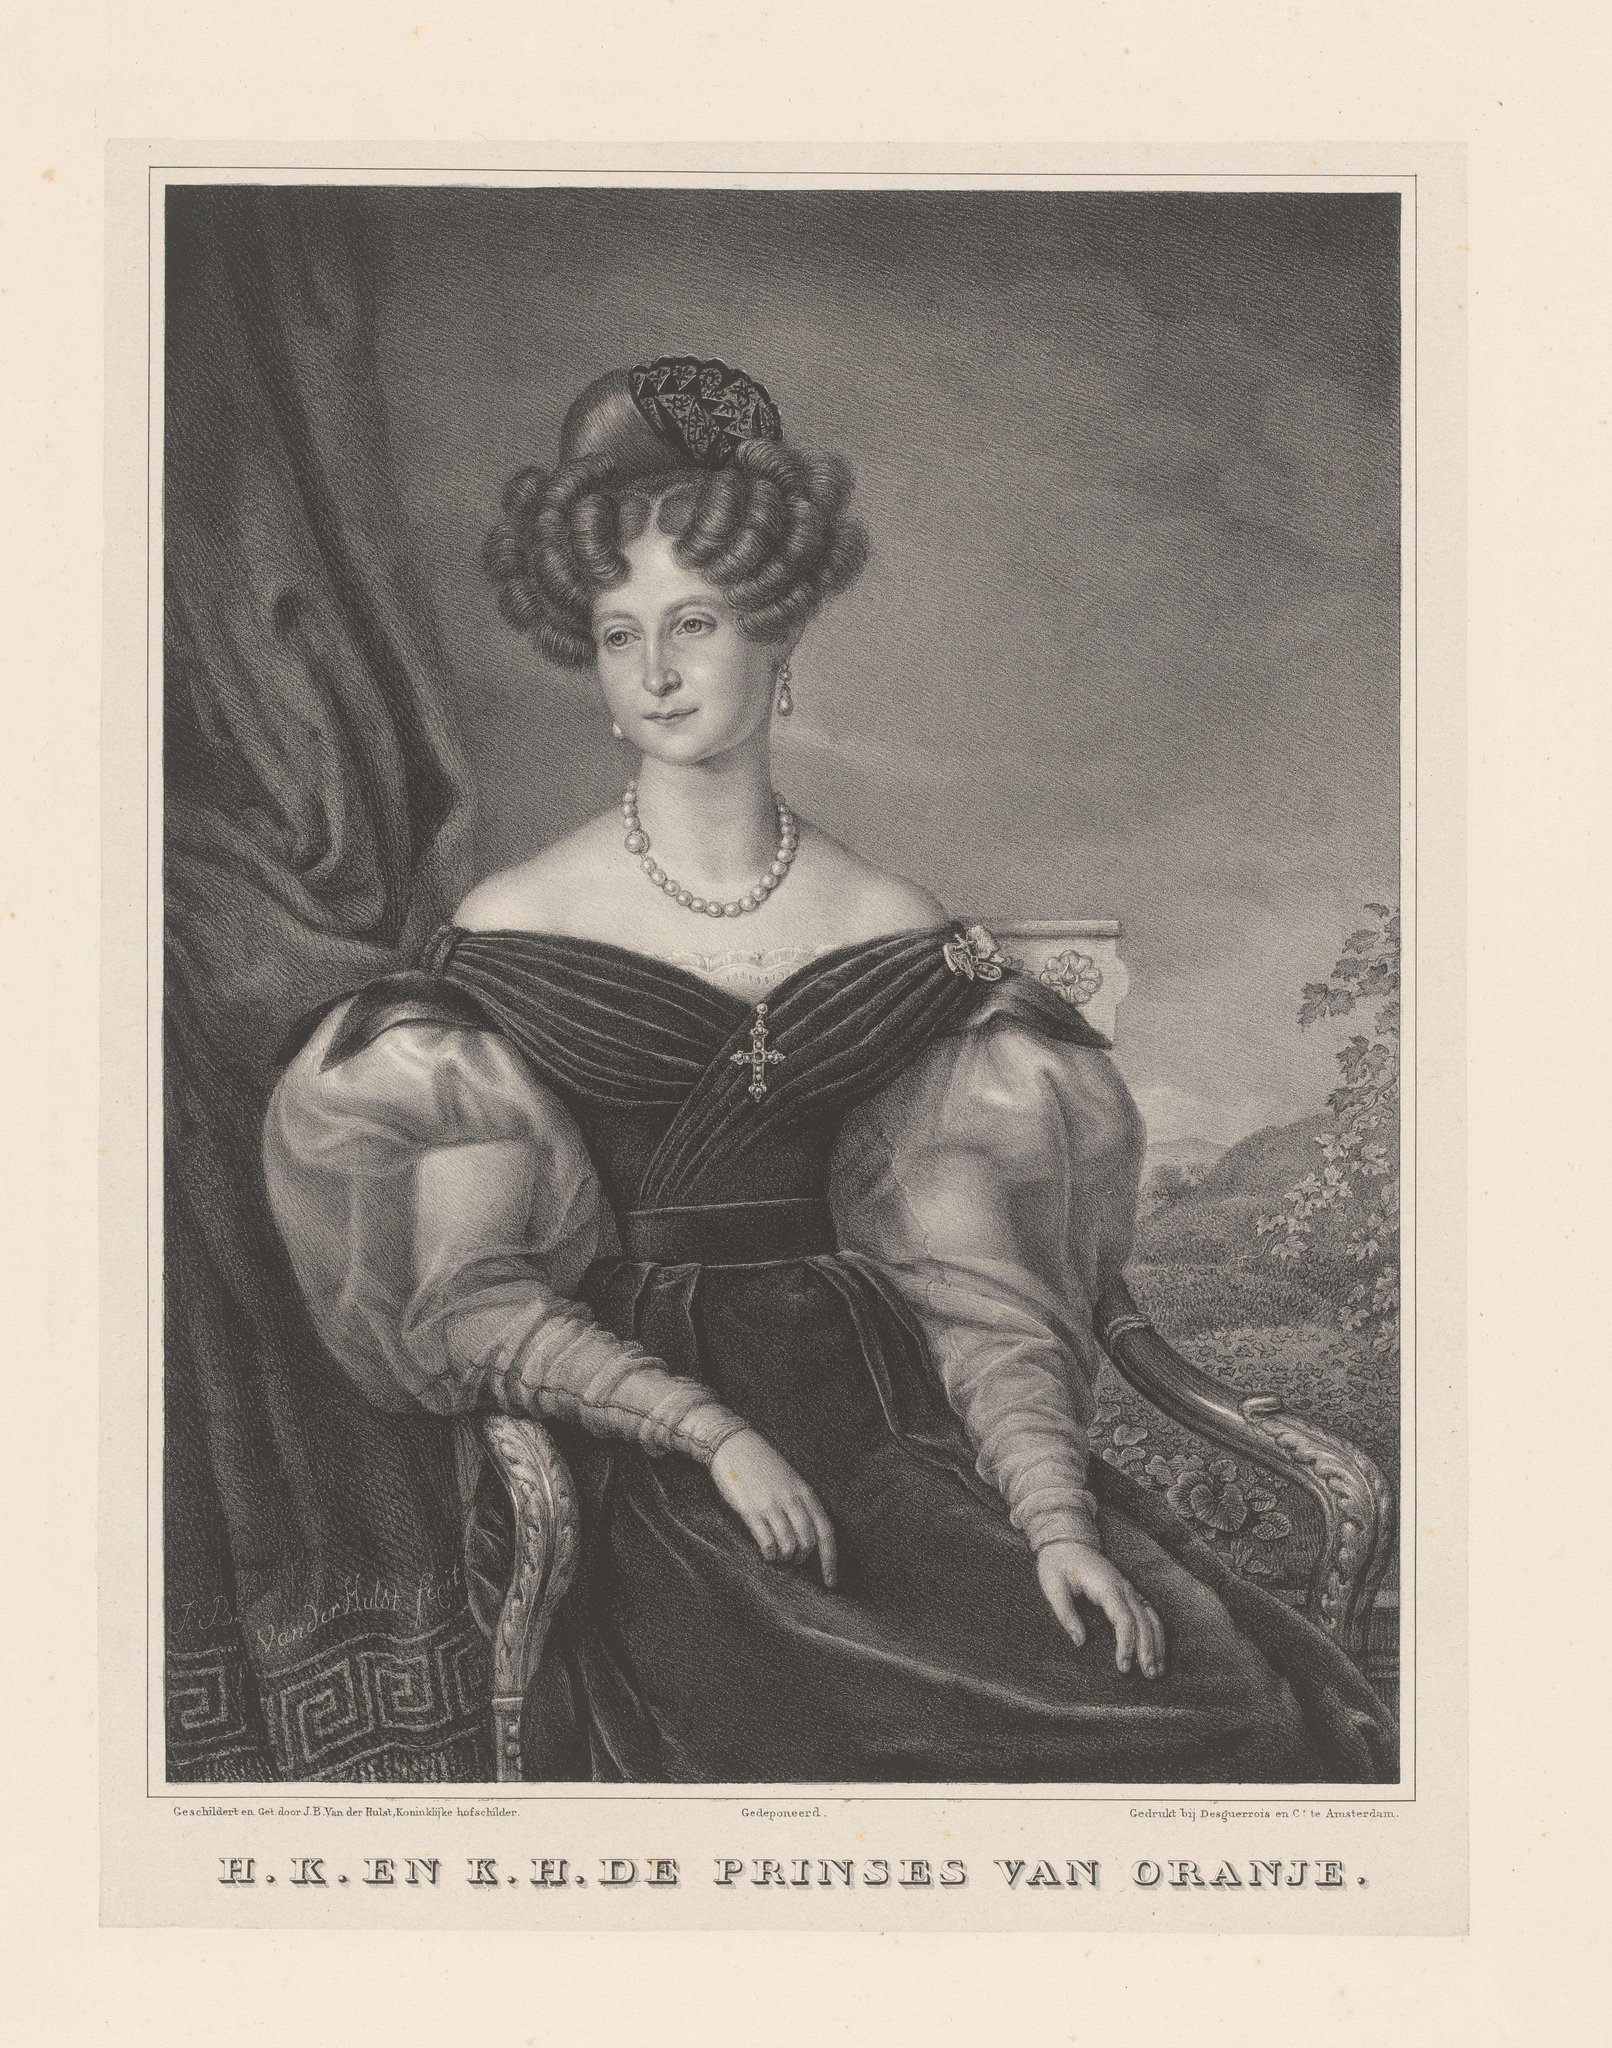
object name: print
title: Portret van Anna Paulowna Romanowa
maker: jean-baptiste van der hulst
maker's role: draughtsman, painter, print maker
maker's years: 1790-1862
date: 1832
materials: paper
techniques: lithograph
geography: amsterdam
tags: anna paulowna romanowa, historical persons - bb - woman, princess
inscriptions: : ‘Gedeponeerd’